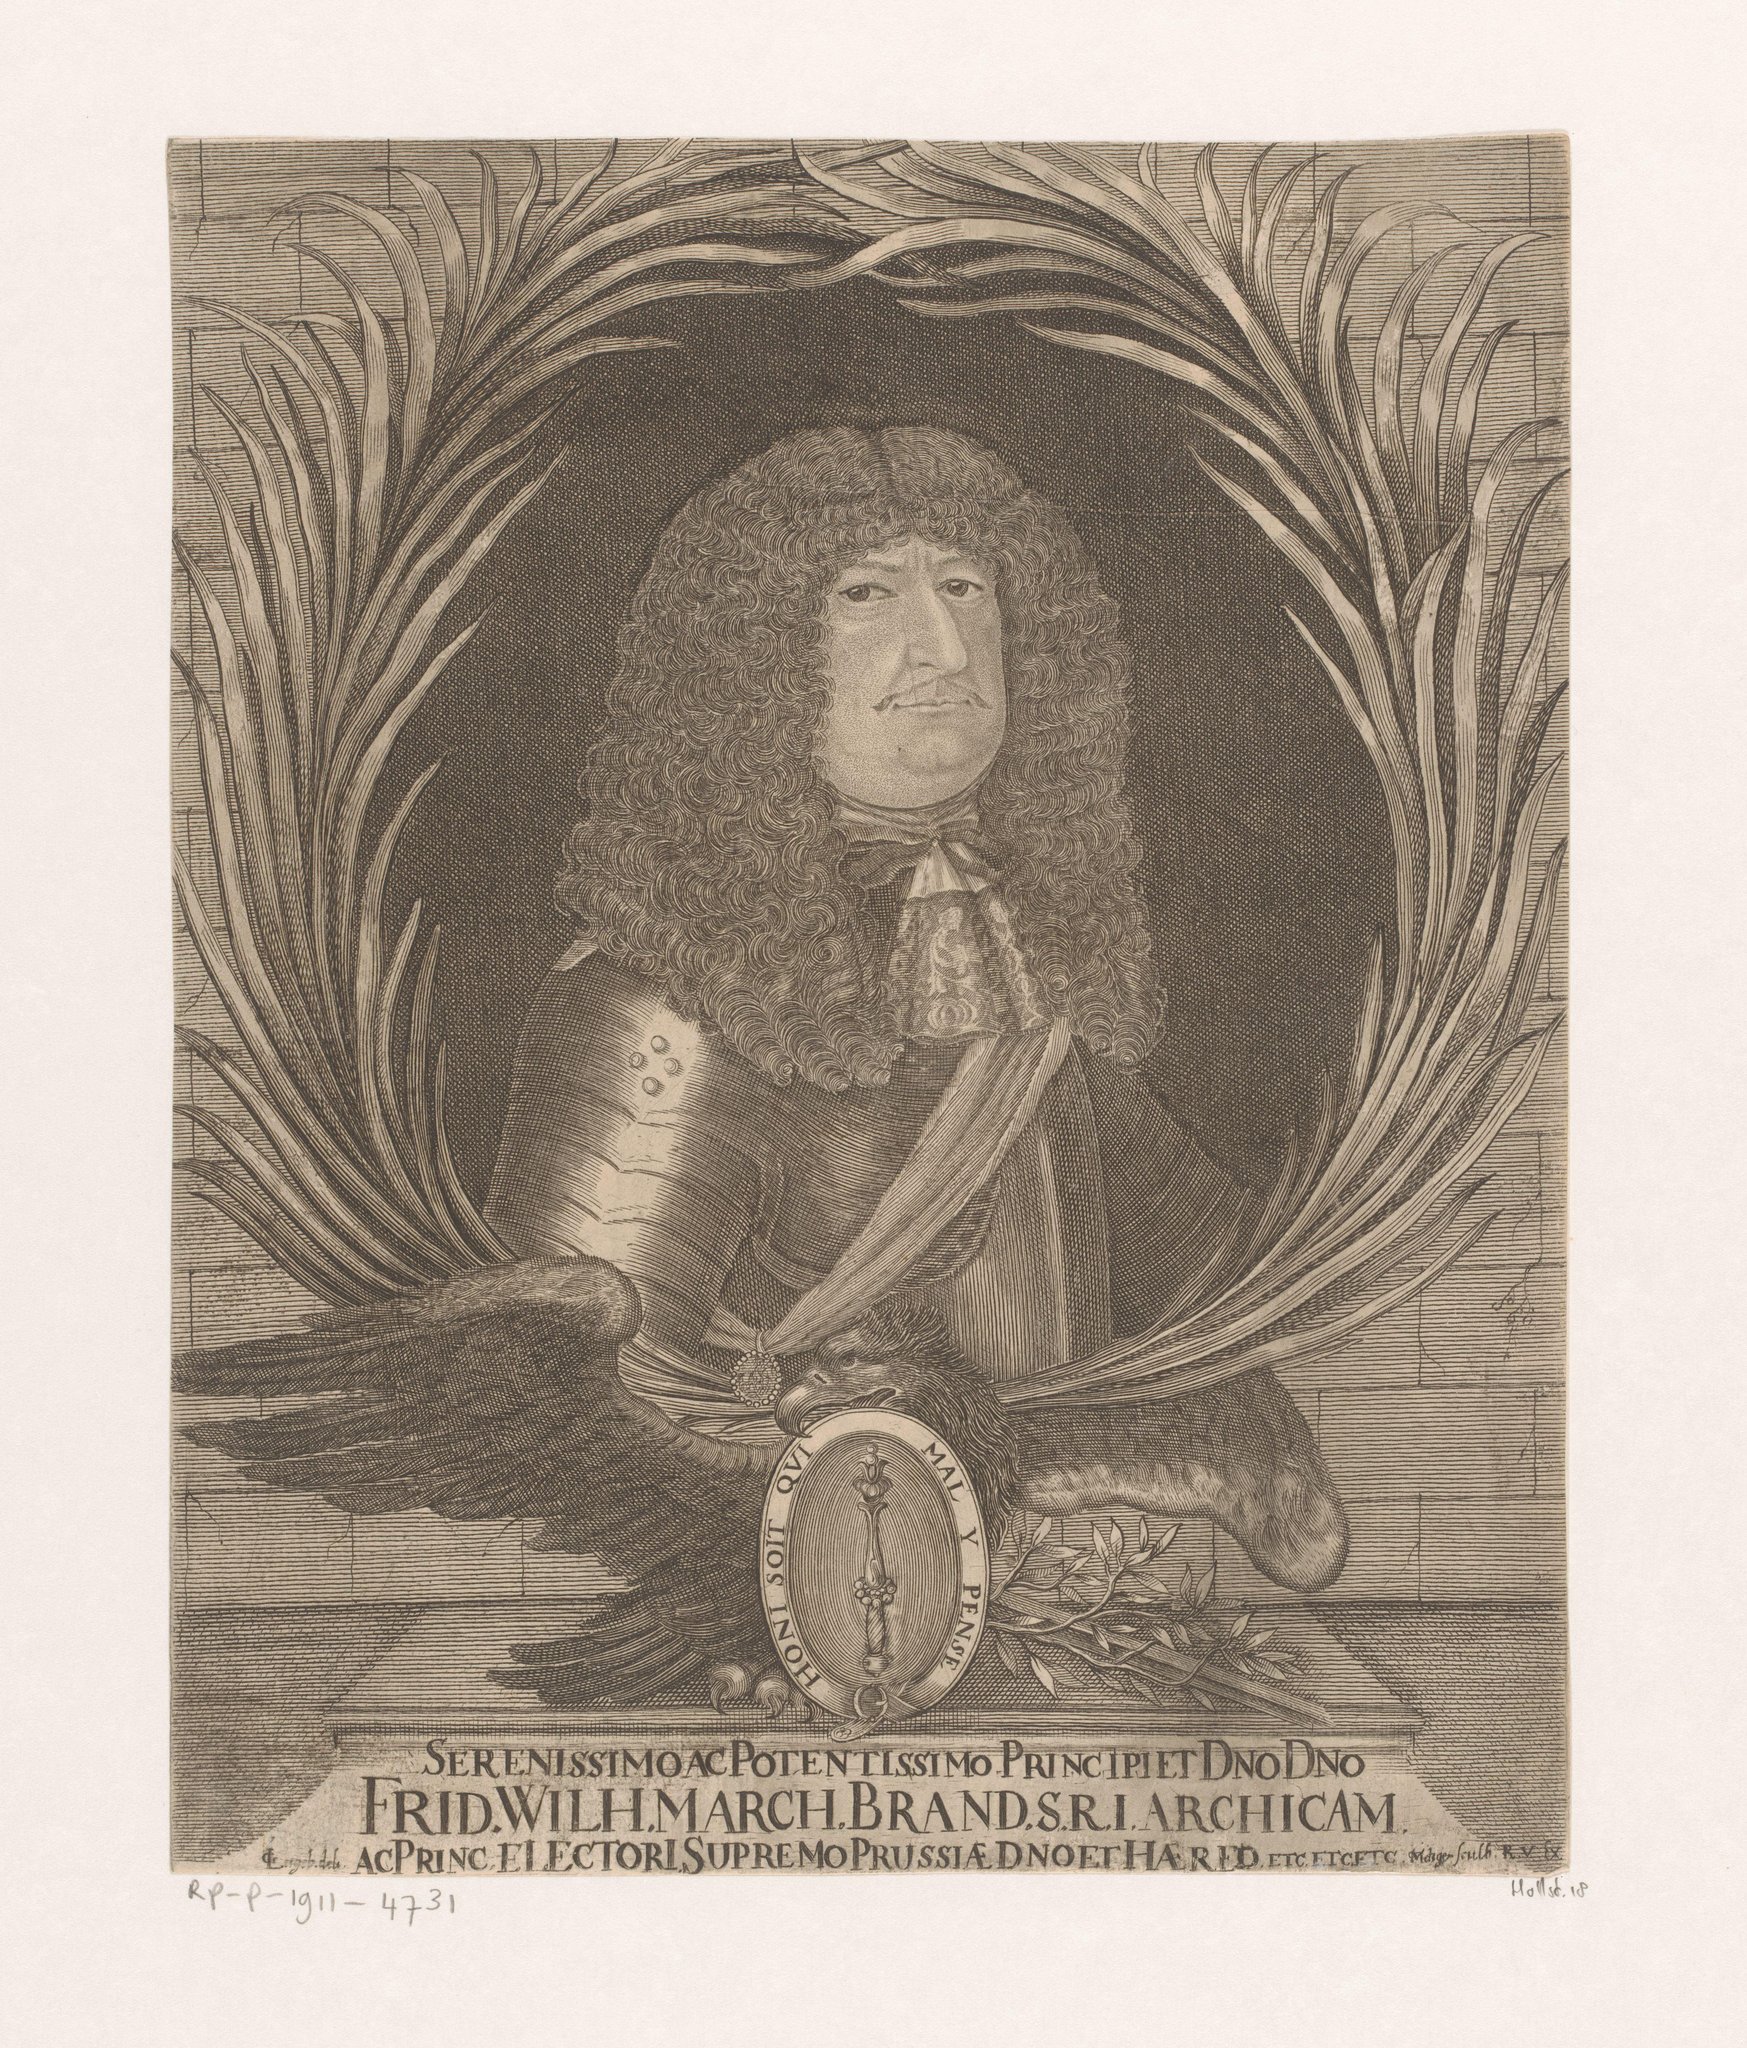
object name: print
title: Portret van Frederik Willem keurvorst van Brandenburg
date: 1660-1680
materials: paper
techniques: engraving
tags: berlin, frederik willem van brandenburg (i), predatory birds: eagle, armour, historical persons, insignia and symbols of sovereignty (crown, diadem, sceptre, orb, seal, standard, cloak, pectoral)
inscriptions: collector's mark: Lugt 2228